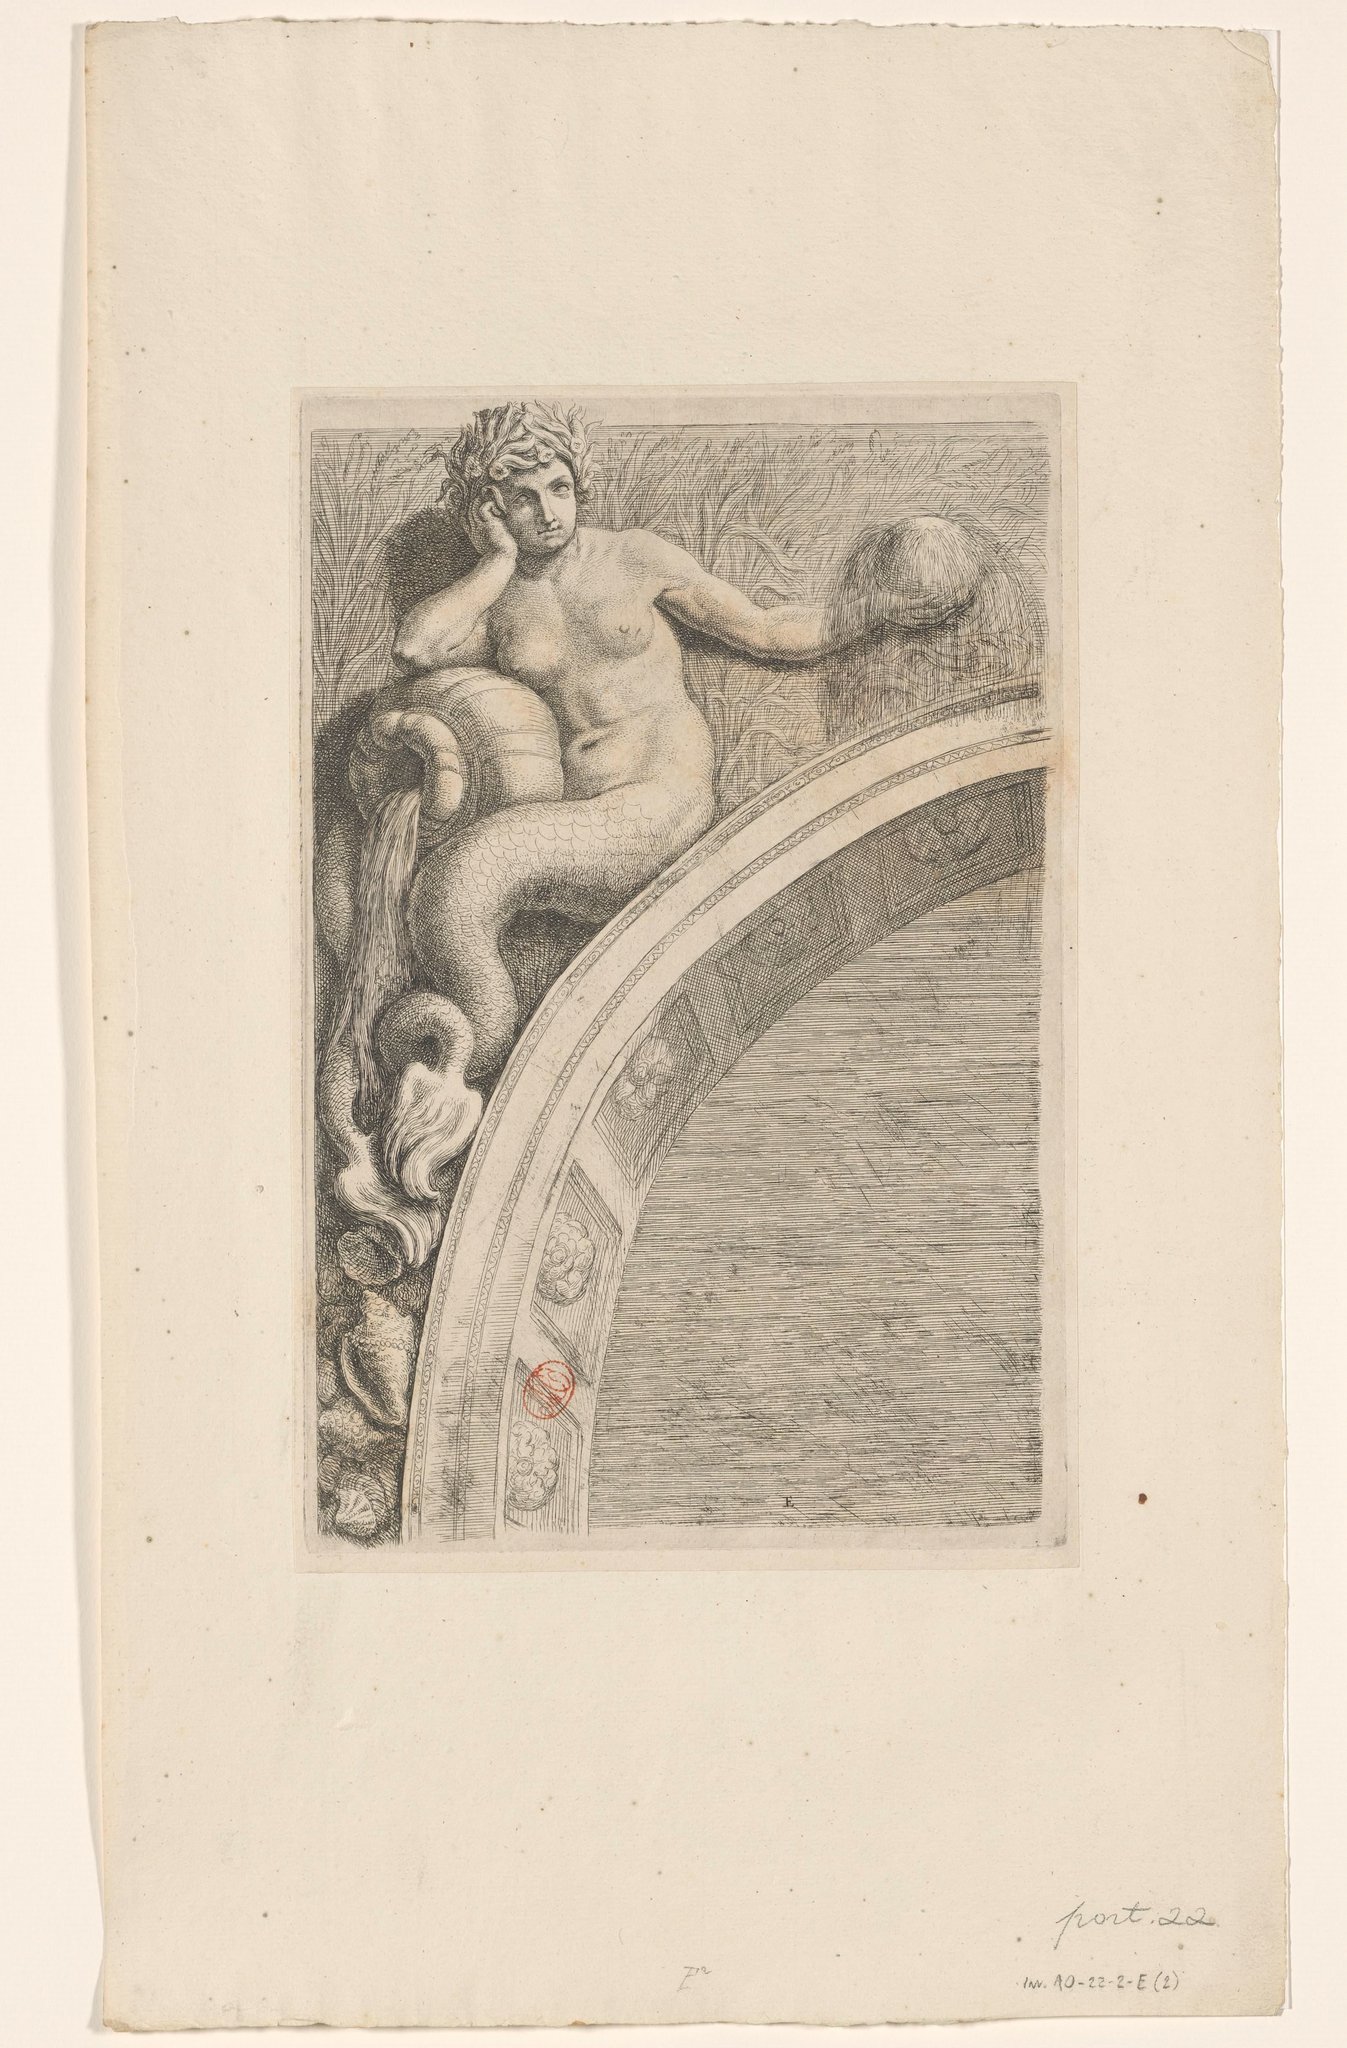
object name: print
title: Reliëf met personificatie van het element Water boven boog aan westzijde van de Burgerzaal in het Stadhuis op de Dam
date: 1663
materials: paper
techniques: engraving, etching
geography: amsterdam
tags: merman - aa - mermaid, siren (+ tail), water (one of the four elements), scallop, shell ~ ornament, container of ceramics: jar, jug, pot, vase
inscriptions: collector's mark: Lugt 195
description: Prent gebruikt in: Secunca pars Praecipuarum effigierum ac ornamentorum amplissime Curiae Amstelrodamensis maiori ex parte in cadido marmore effectorum per Artum Quellinium eiusdem Civitatis Statuarium / Het tweede deel Van de voornaemste Statuen ende Cieraten van 't konst-rijcke Stadt-huys van Amstelredam 'tmeeste in Marmer gemaeckt door Artus Quellinus Beelthouwer der voorseyde Stadt. Amsterdam: Artus Quellinus (I), 1663. Zie RP-P-AO-22-2-1 voor bijhorende titelpagina. Zie RP-P-AO-22-2-2 voor bijhorend register. Zie RP-P-AO-22-2A, RP-P-AO-22-2B, RP-P-AO-22-2C-1, RP-P-AO-22-2C-2, RP-P-AO-22-2C-3, RP-P-AO-22-2C-4, RP-P-AO-22-2D-1, RP-P-AO-22-2D-2, RP-P-AO-22-2D-3, RP-P-AO-22-2E-1, RP-P-AO-22-2E-3, RP-P-AO-22-2E-4, RP-P-AO-22-2F-1, RP-P-AO-22-2F-2, RP-P-AO-22-2F-3, RP-P-AO-22-2G, RP-P-AO-22-2H, RP-P-AO-22-2I, RP-P-AO-22-2K, RP-P-AO-22-2L, RP-P-AO-22-2M, RP-P-AO-22-2N, RP-P-AO-22-2O-1, RP-P-AO-22-2O-2, RP-P-AO-22-2O-3, RP-P-AO-22-2O-4, RP-P-AO-22-2O-5, RP-P-AO-22-2O-6, RP-P-AO-22-2O-7, RP-P-AO-22-2P-1, RP-P-AO-22-2P-2, RP-P-AO-22-2Q-1, RP-P-AO-22-2Q-2, RP-P-AO-22-2Q-3, RP-P-AO-22-2R-1, RP-P-AO-22-2R-2, RP-P-AO-22-2R-3, RP-P-AO-22-2S, RP-P-AO-22-2T-1, RP-P-AO-22-2T-2, RP-P-AO-22-2T-3, RP-P-AO-22-2T-4, RP-P-AO-22-2V-1, RP-P-AO-22-2V-2, RP-P-AO-22-2W-1, RP-P-AO-22-2W-2, RP-P-AO-22-2X-1, RP-P-AO-22-2X-2 en RP-P-AO-22-2X-3 voor andere prenten uit deze publicatie. Zelfde staat van prent ook gebruikt in: Secunca pars Praecipuarum effigierum ac ornamentorum amplissime Curiae Amstelrodamensis maiori ex parte in cadido marmore effectorum per Artum Quellinium eiusdem Civitatis Statuarium / Het tweede deel Van de voornaemste Statuen ende Cieraten van 't konst-rijcke Stadt-huys van Amstelredam 'tmeeste in Marmer gemaeckt door Artus Quellinus Beelthouwer der voorseyde Stadt. Amsterdam: Frederik de Wit, 1668. Latere staat van prent ook gebruikt in: Architecture peinture et sculpture de la Maison de Ville d'Amsterdam, representee en CIX. figures en taille-douce (…). Amsterdam: David Mortier, 1719. En in: Architecture peinture et sculpture de la Maison de Ville d'Amsterdam, representee en CIX. figures en taille-douce (…). Amsterdam: Gerard Valck, 1719. En in: Bouw schilder en beeldhouwkonst, van het Stadhuis te Amsteldam, vertoont in CIX figuuren (…). Amsterdam: Covens & Mortier & Covens Jr., s.a. (1774-1783).